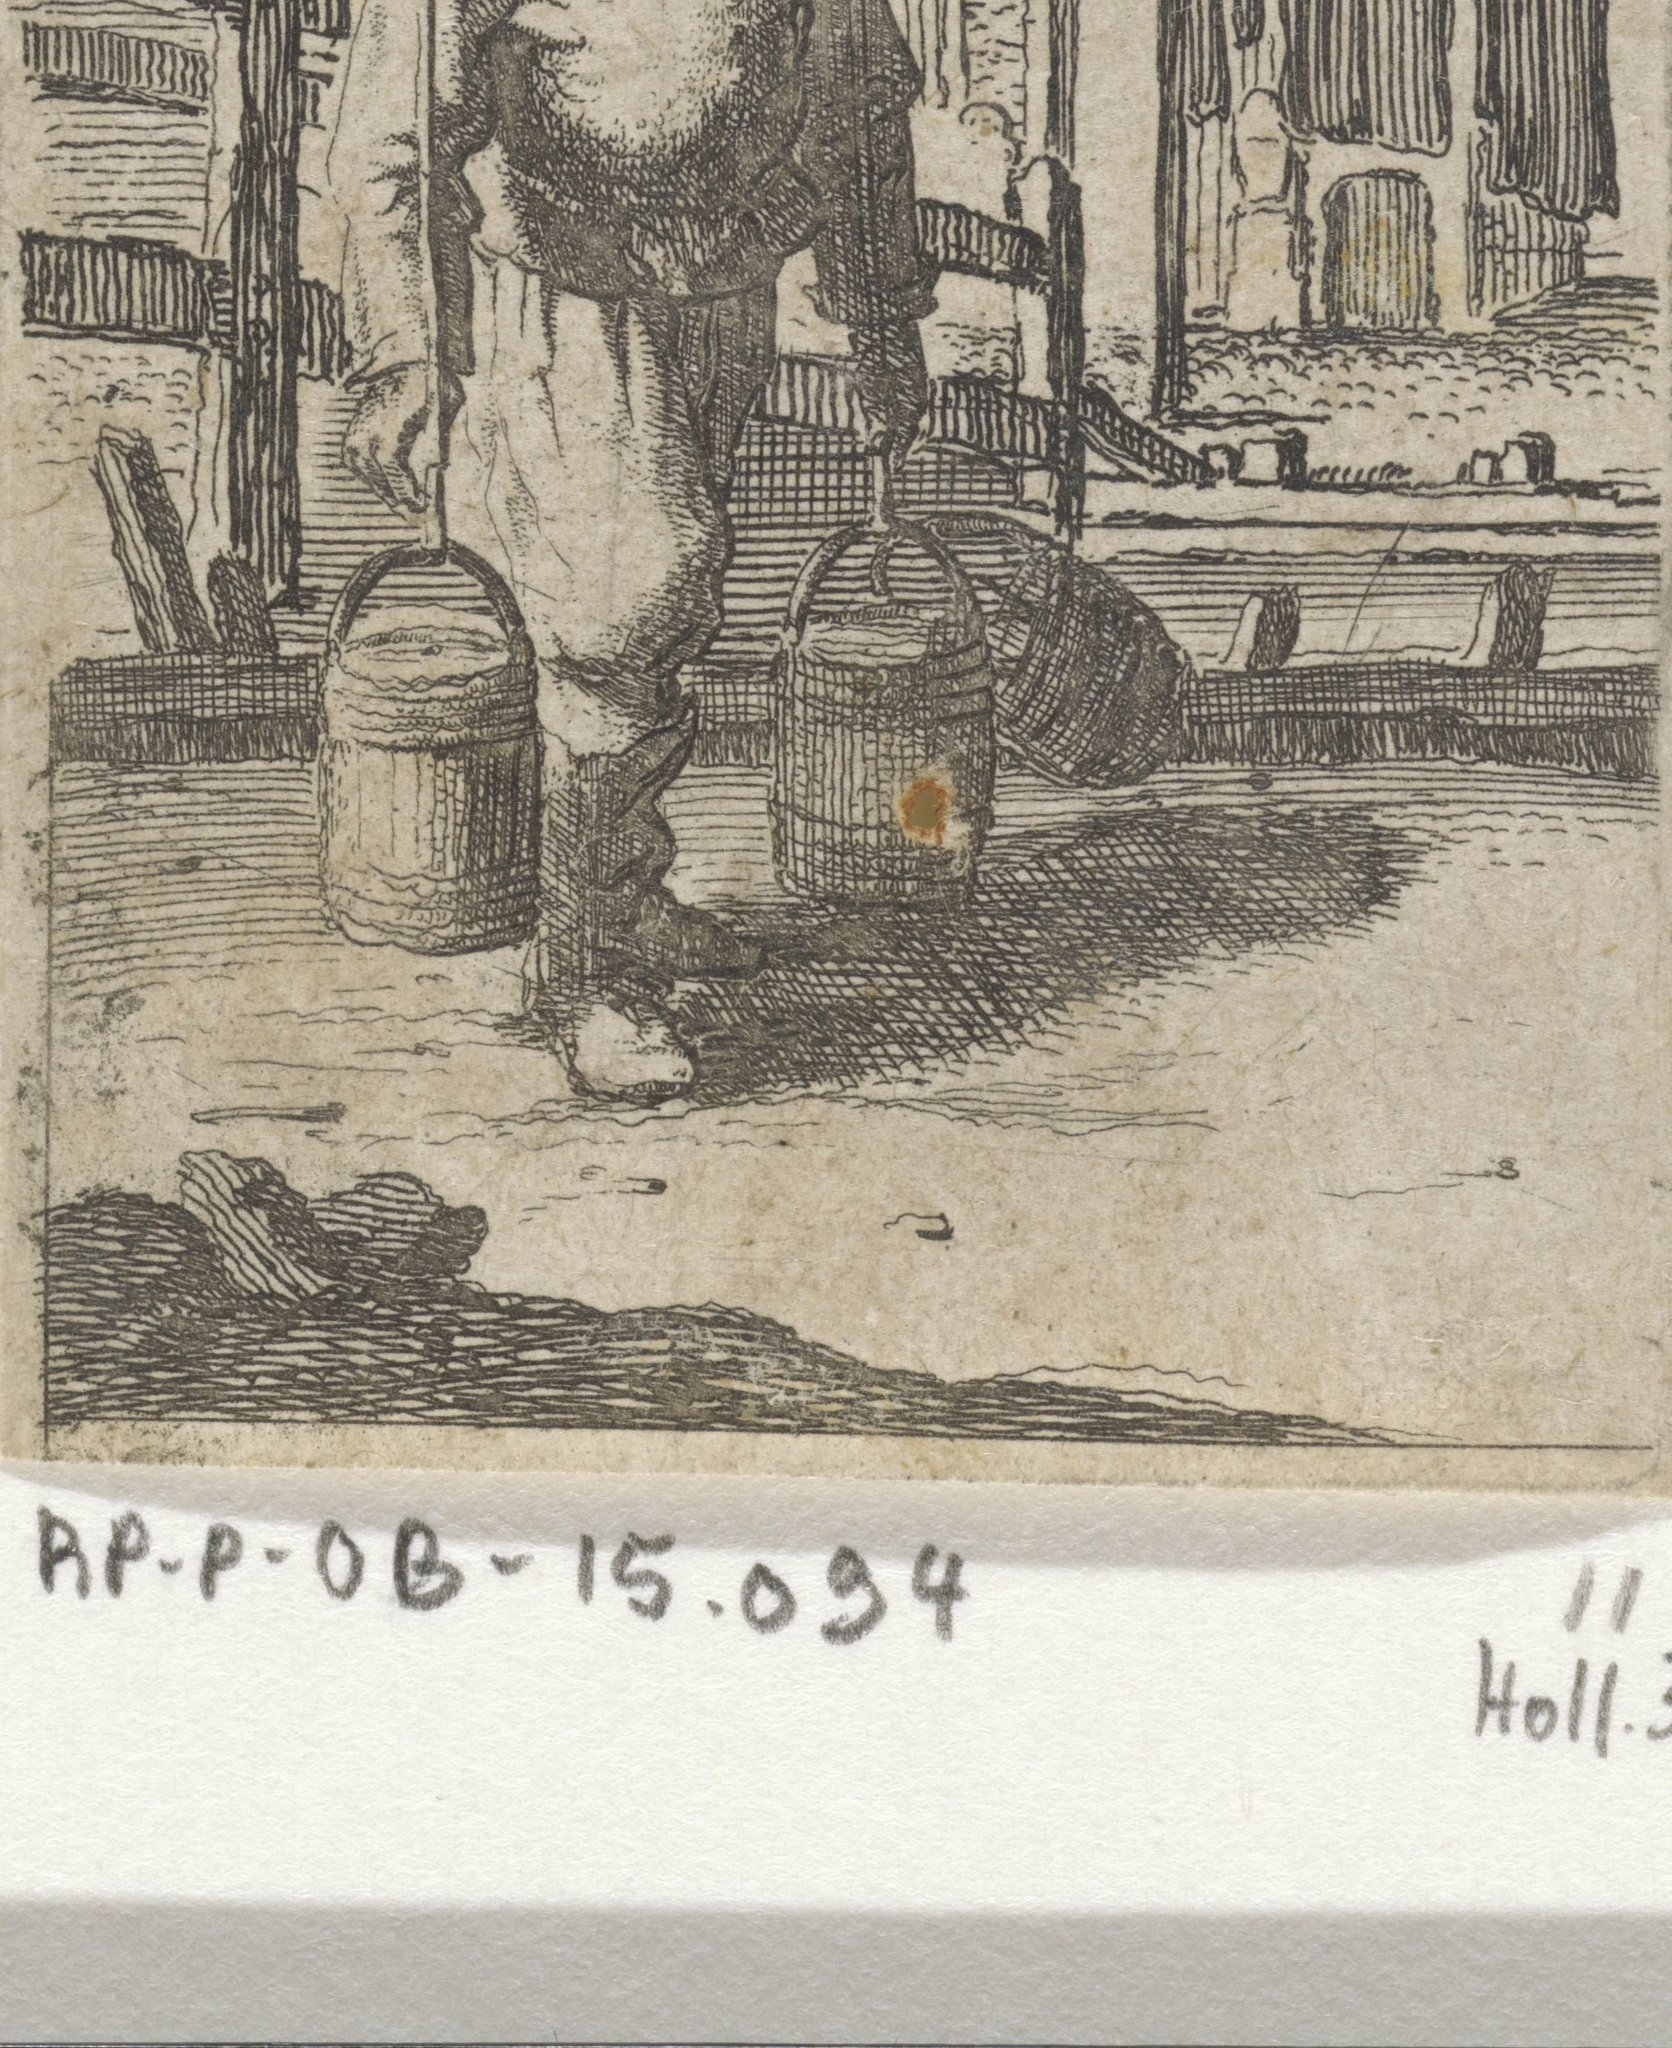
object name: print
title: Man met een juk met emmers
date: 1618-1638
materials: paper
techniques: etching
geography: haarlem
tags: carrying something with yoke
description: Een man draagt een juk met daaraan twee emmers. Op de achtergrond een houten brug en een huis. De prent maakt deel uit van een serie van 32 prenten met genretaferelen.